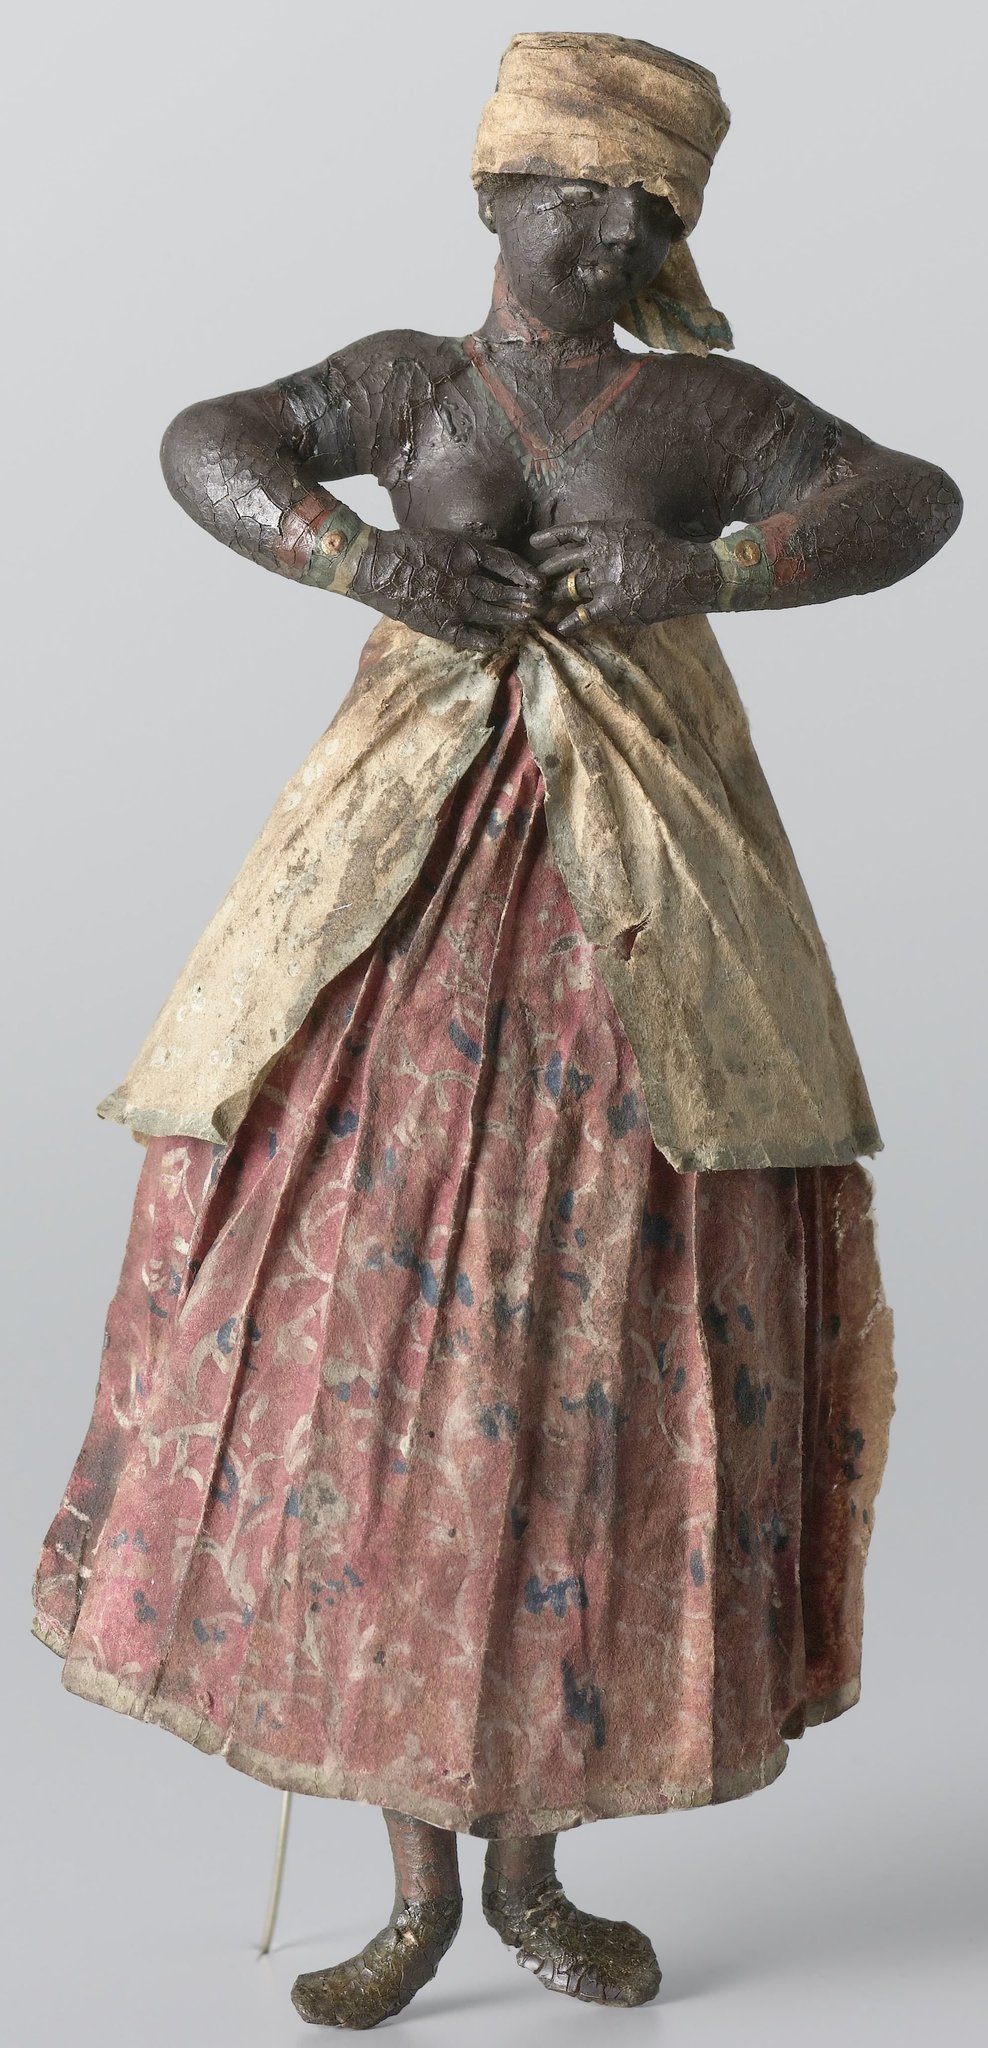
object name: diorama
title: Een Creoolse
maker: gerrit schouten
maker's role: draughtsman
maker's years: 1779-1839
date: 1810-1839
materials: glue, paint, paper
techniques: modeling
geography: suriname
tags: suriname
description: Een los figuur uit een diorama van Gerrit Schouten, voorstellende een Creoolse vrouw, staand. Haar beide handen voor haar borsten houdend. De vrouw draagt een lange geplooide rok, rood met een bloemmotief in blauw en wit. Over deze rok draagt ze een witte effen omslagdoek (pangi). Ze draagt armbanden, een ketting en een hoofddoek. Haar bovenlichaam is onbedekt. Ze is blootvoets.